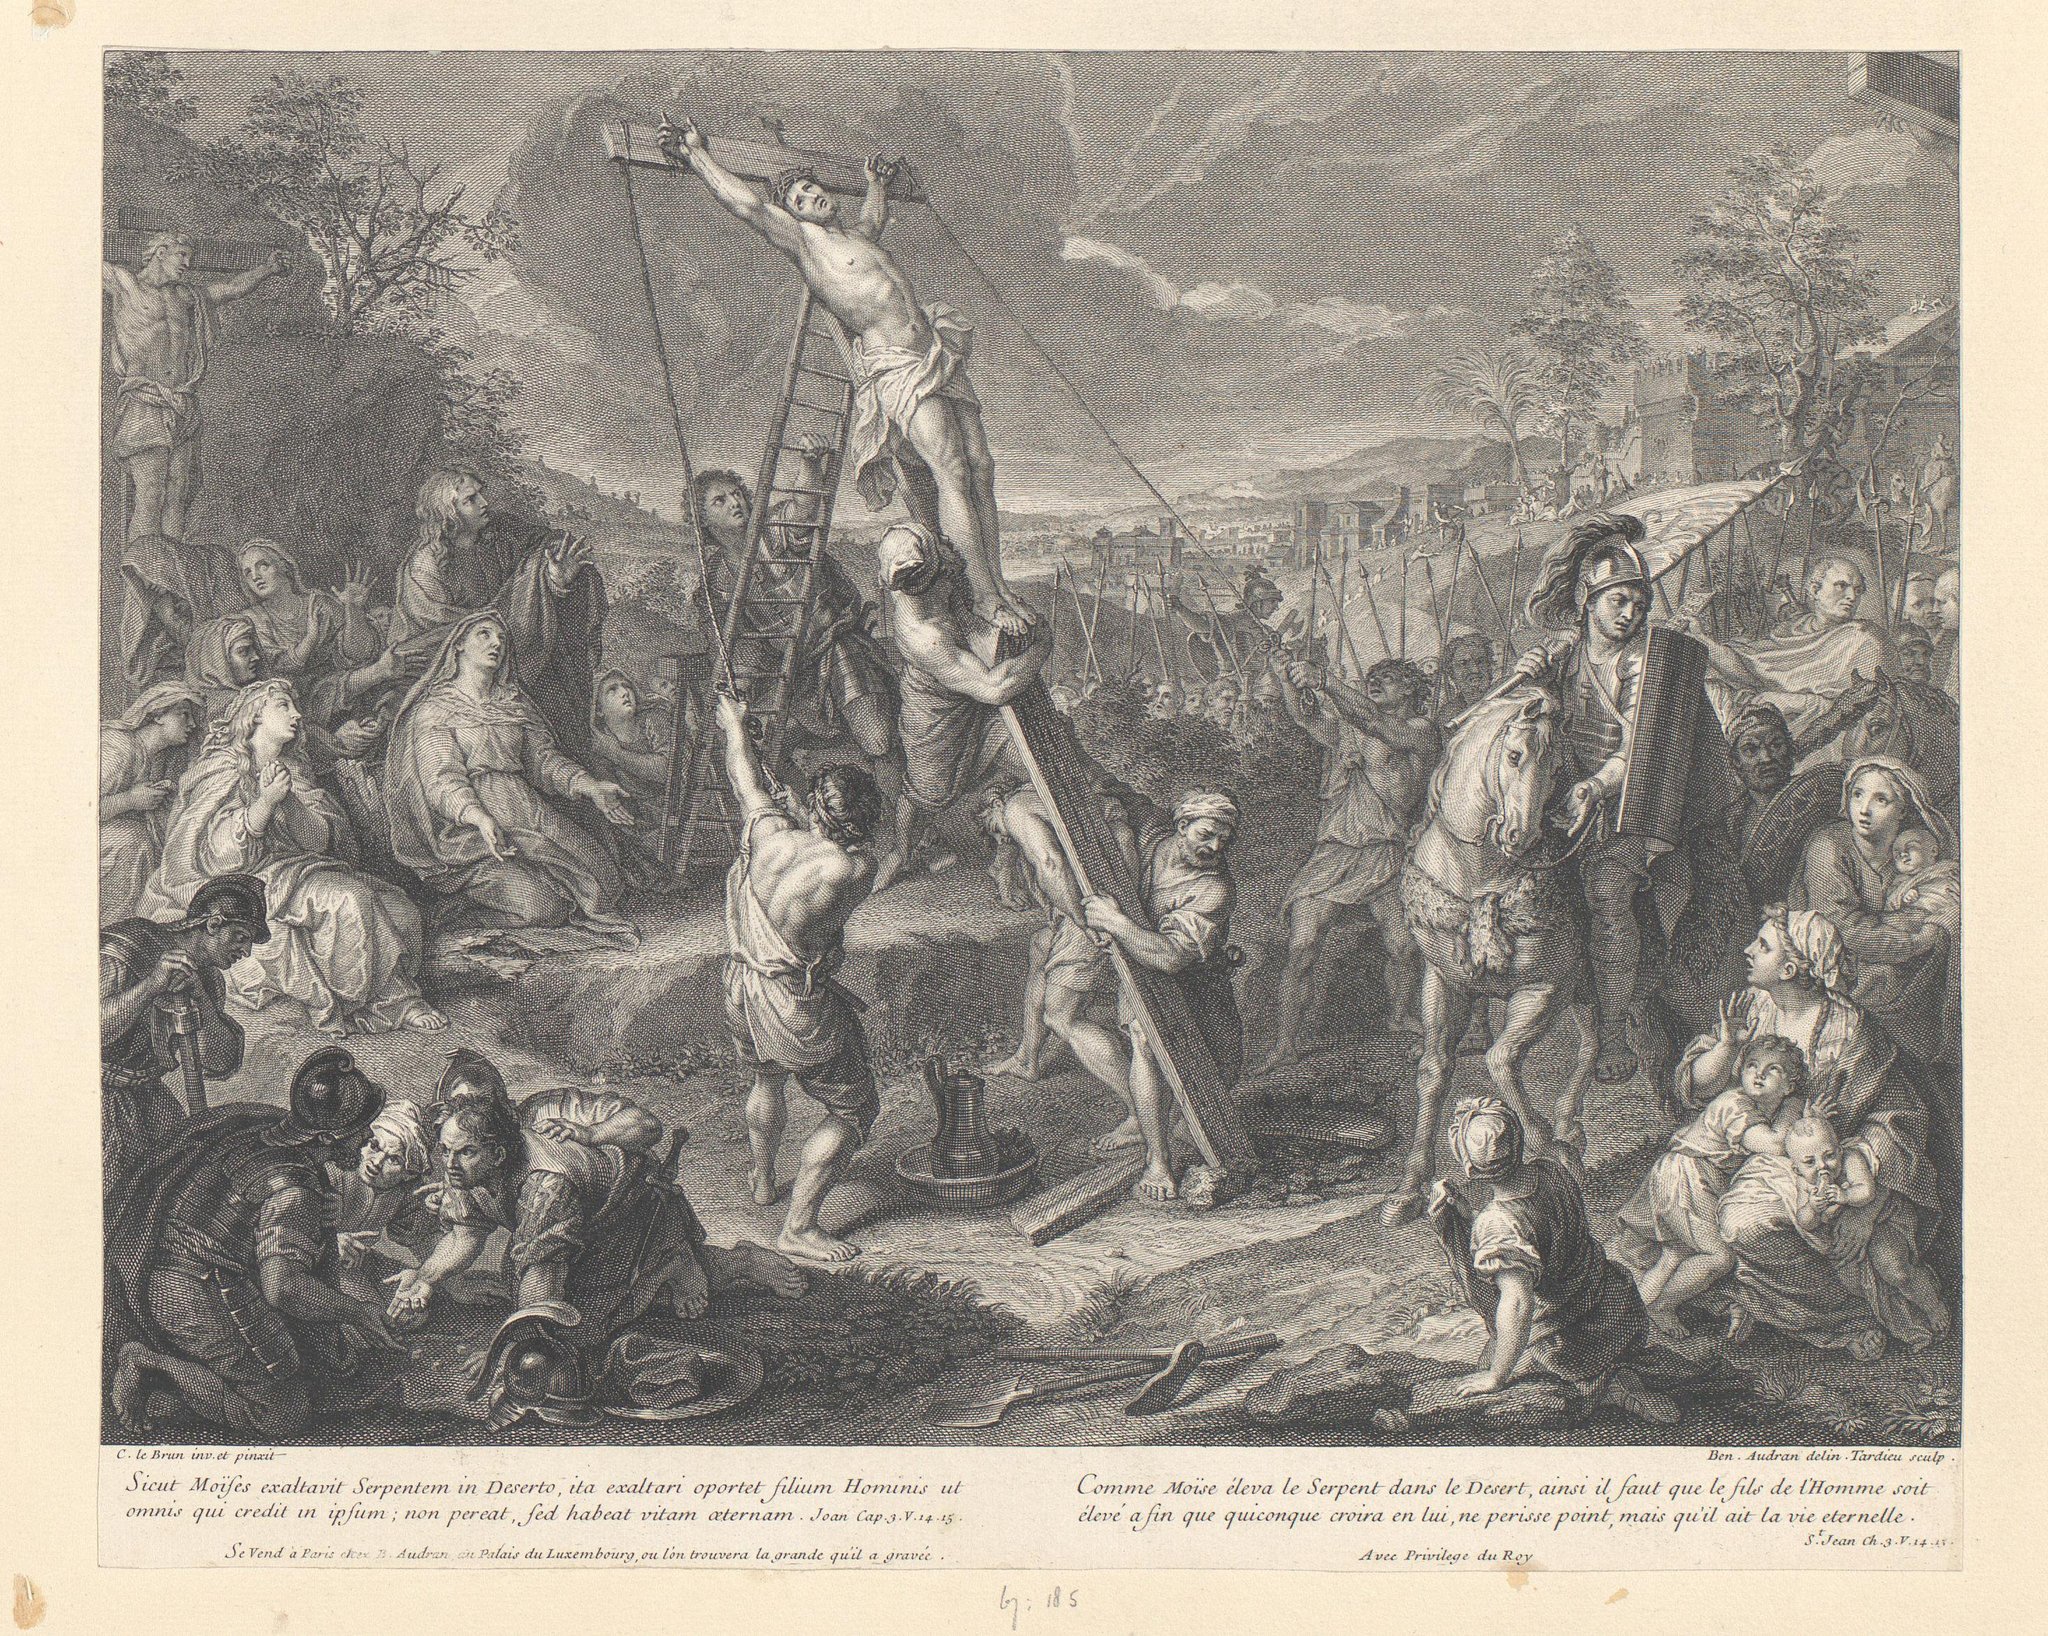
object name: album leaf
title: L'ouvrage de Charles le Brun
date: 1684-1749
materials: paper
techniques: engraving, etching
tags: raising of the cross to which christ is nailed already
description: Deze prent maakt deel uit van een album.